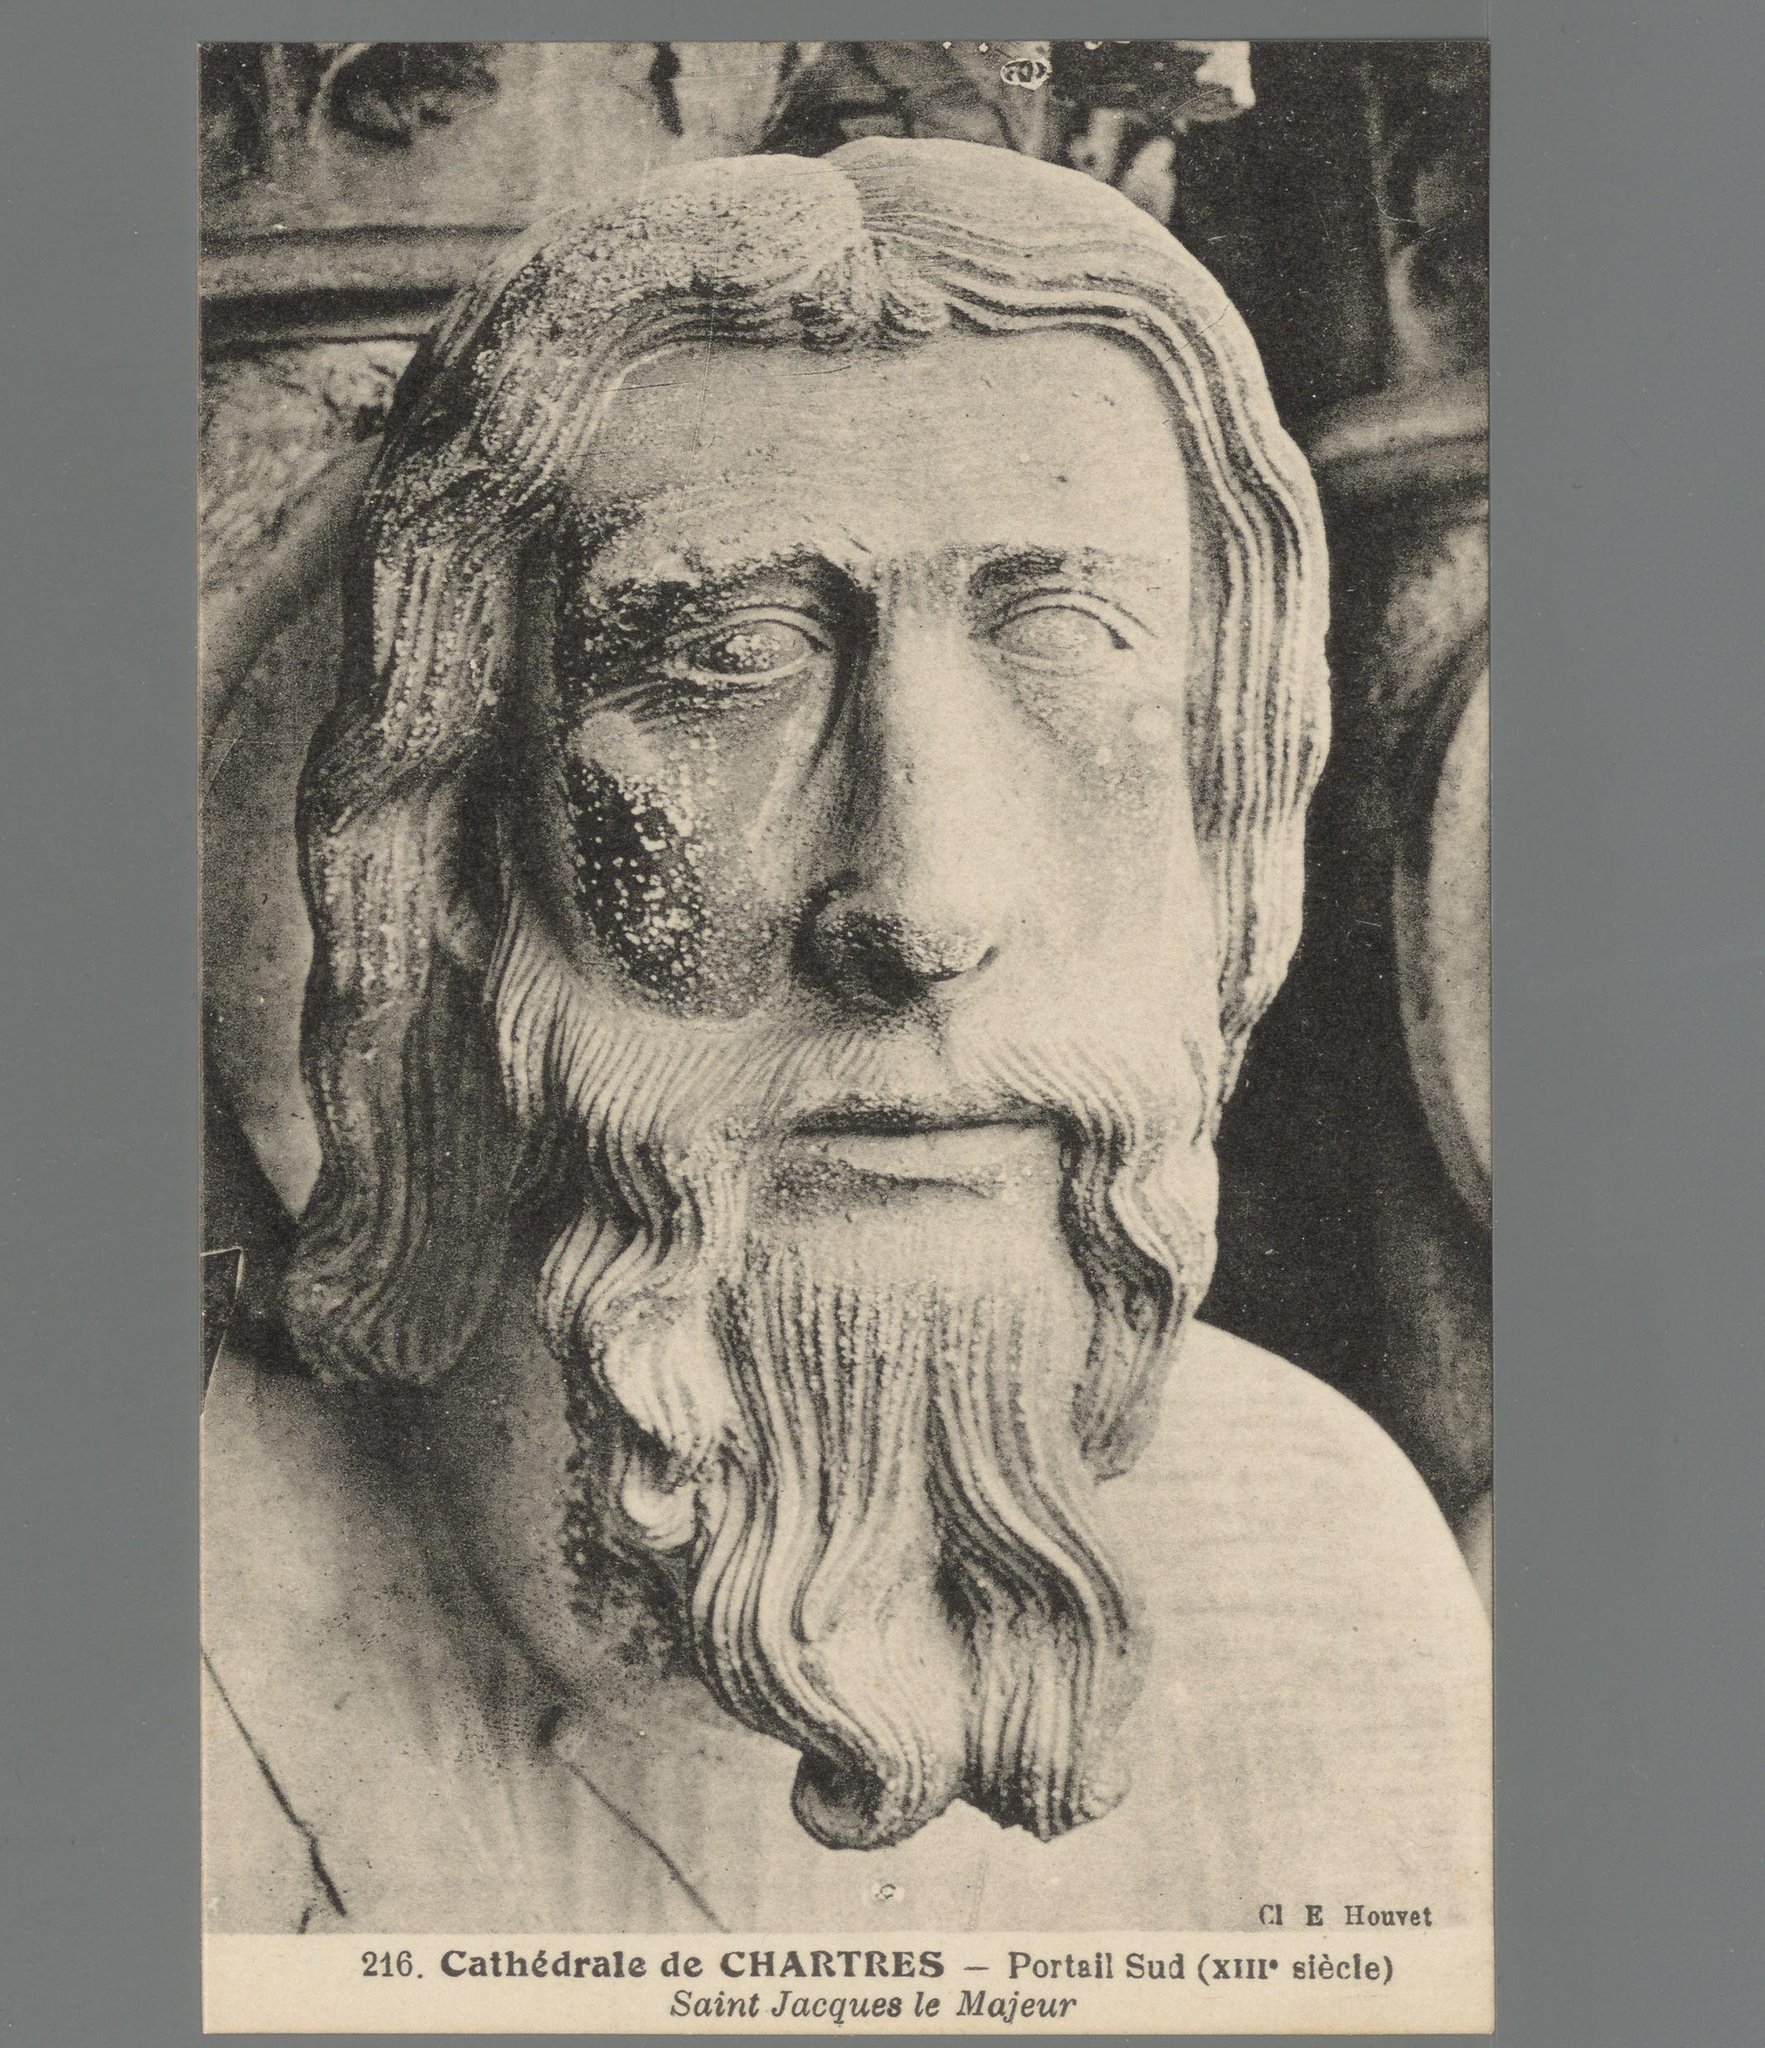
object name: photomechanical print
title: Cathédrale de Chartres - Portail Sud (XIIIe siècle). Saint Jacques le Majeur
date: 1903-1930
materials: cardboard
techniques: photograph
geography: chartres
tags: church (exterior), statues, paintings, etc. ~ objects of worship in roman religion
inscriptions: collector's mark: ‘AFE v S’